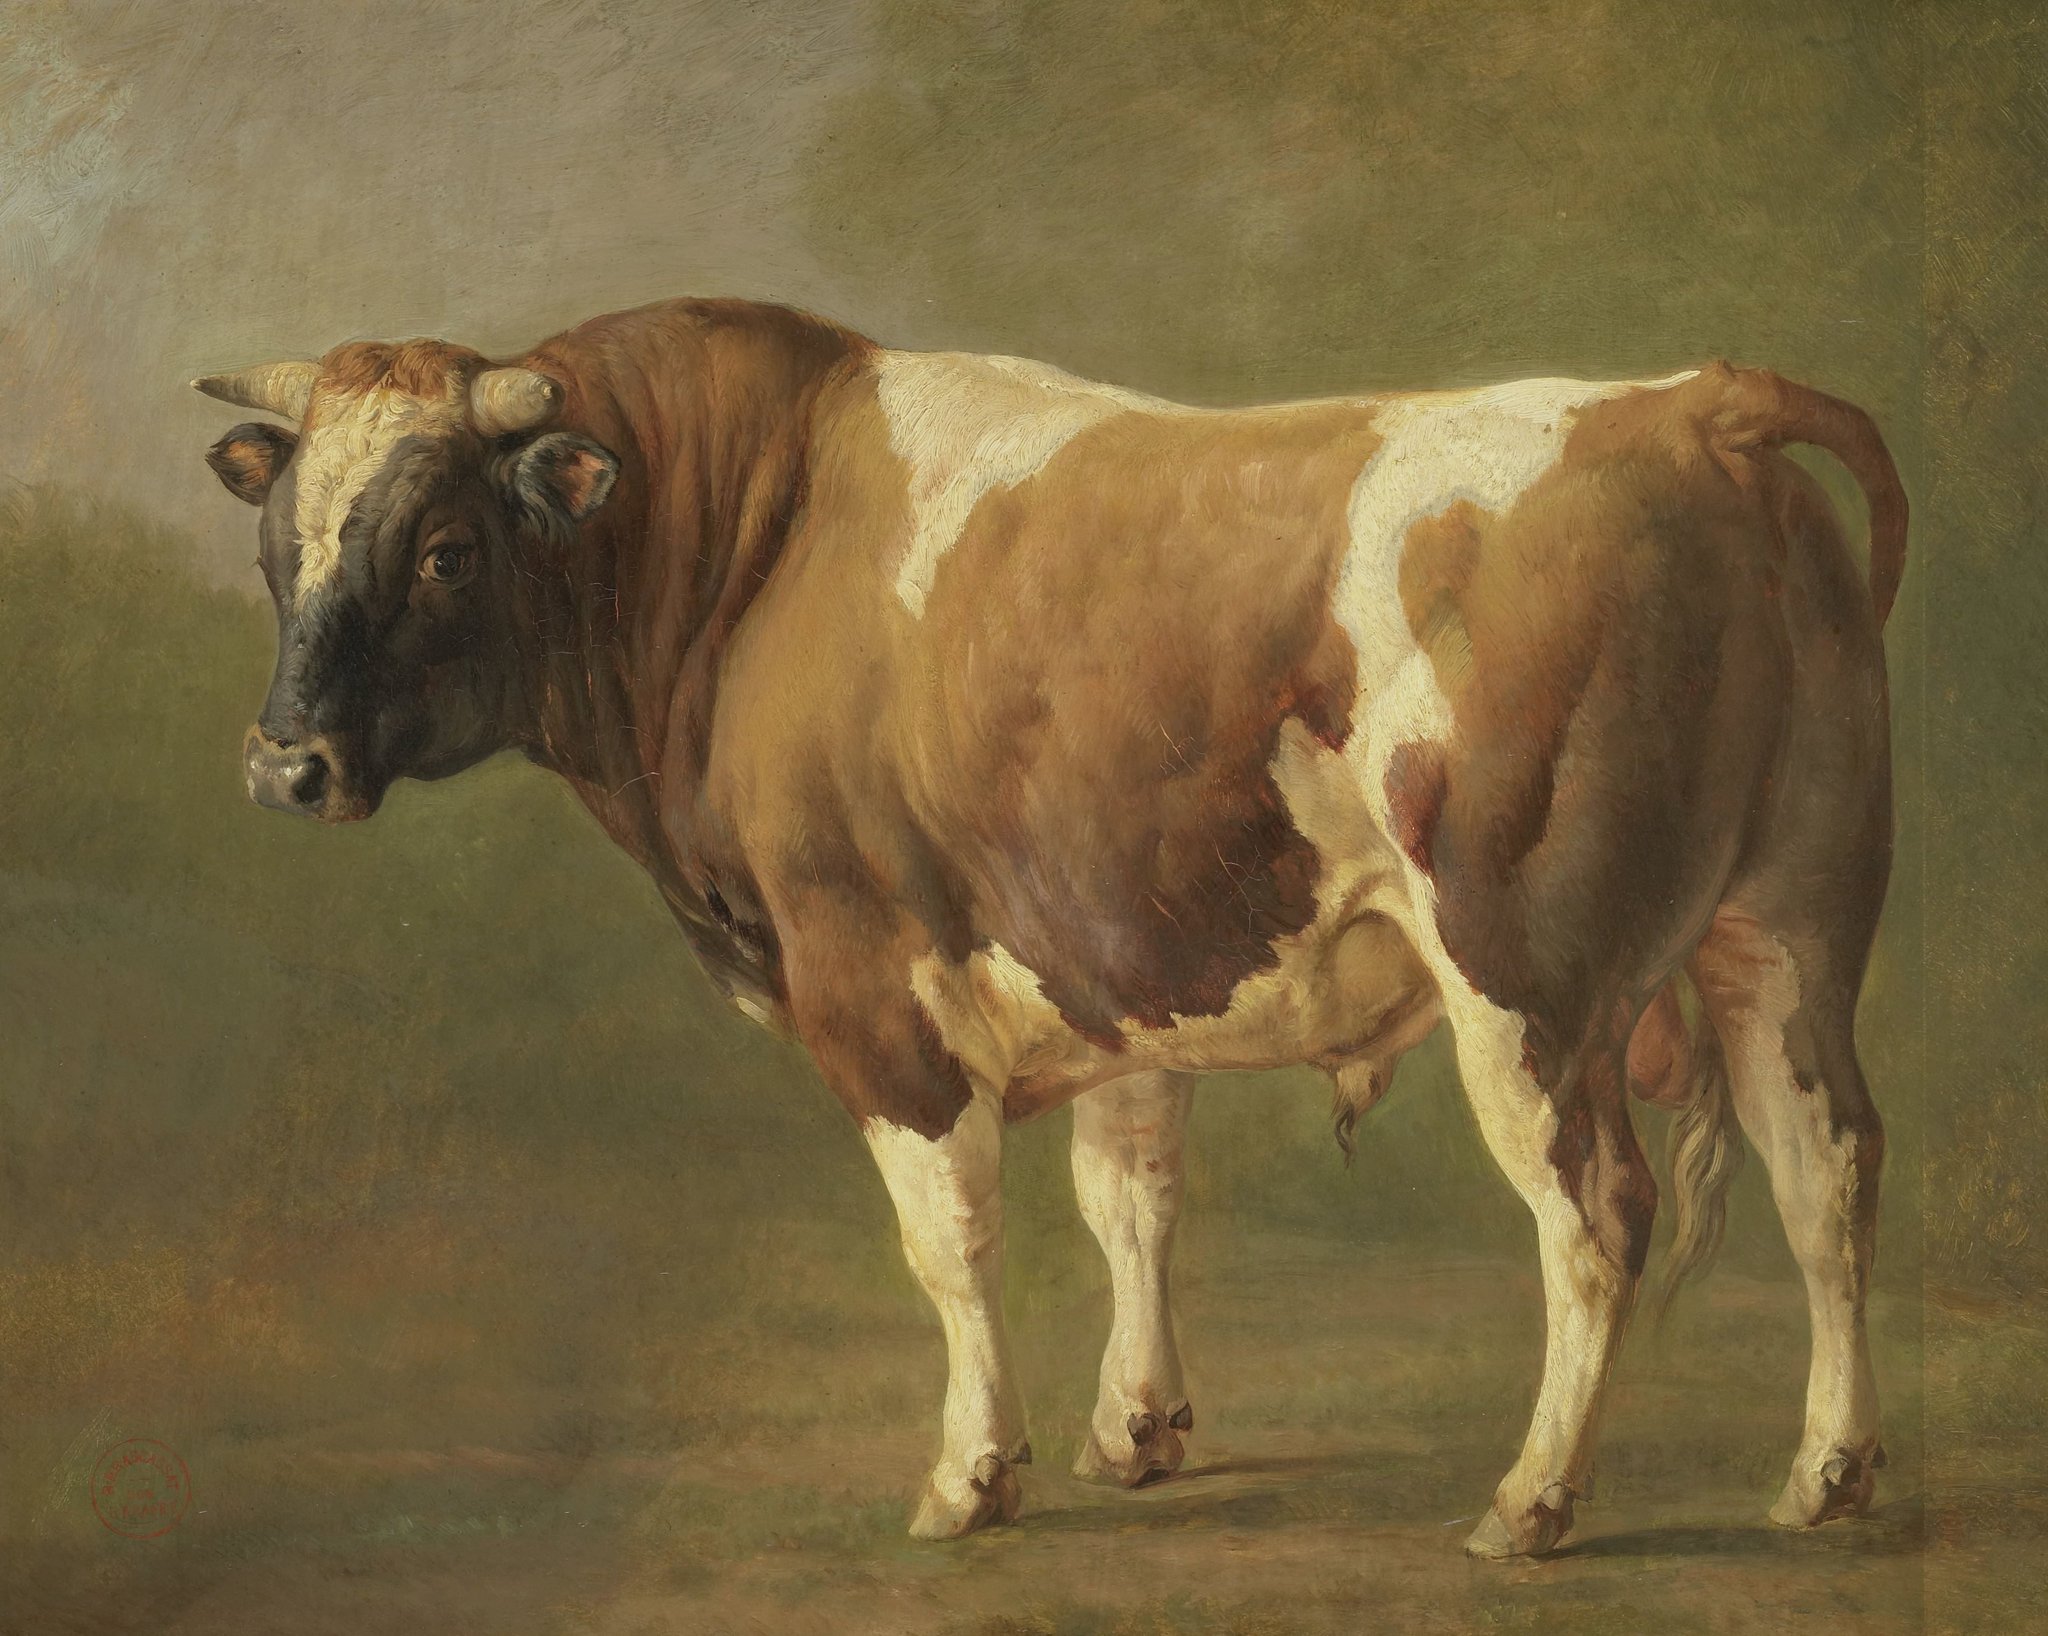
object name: painting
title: Study of a Bull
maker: jacques raymond brascassat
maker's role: draughtsman, print maker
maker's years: 1804-1867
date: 1830-1867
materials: canvas, oil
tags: bull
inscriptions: signature: ‘J.R. Brascassat,’, inscription: ‘don H. Krafft’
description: Studie van een stier, staande naar links.